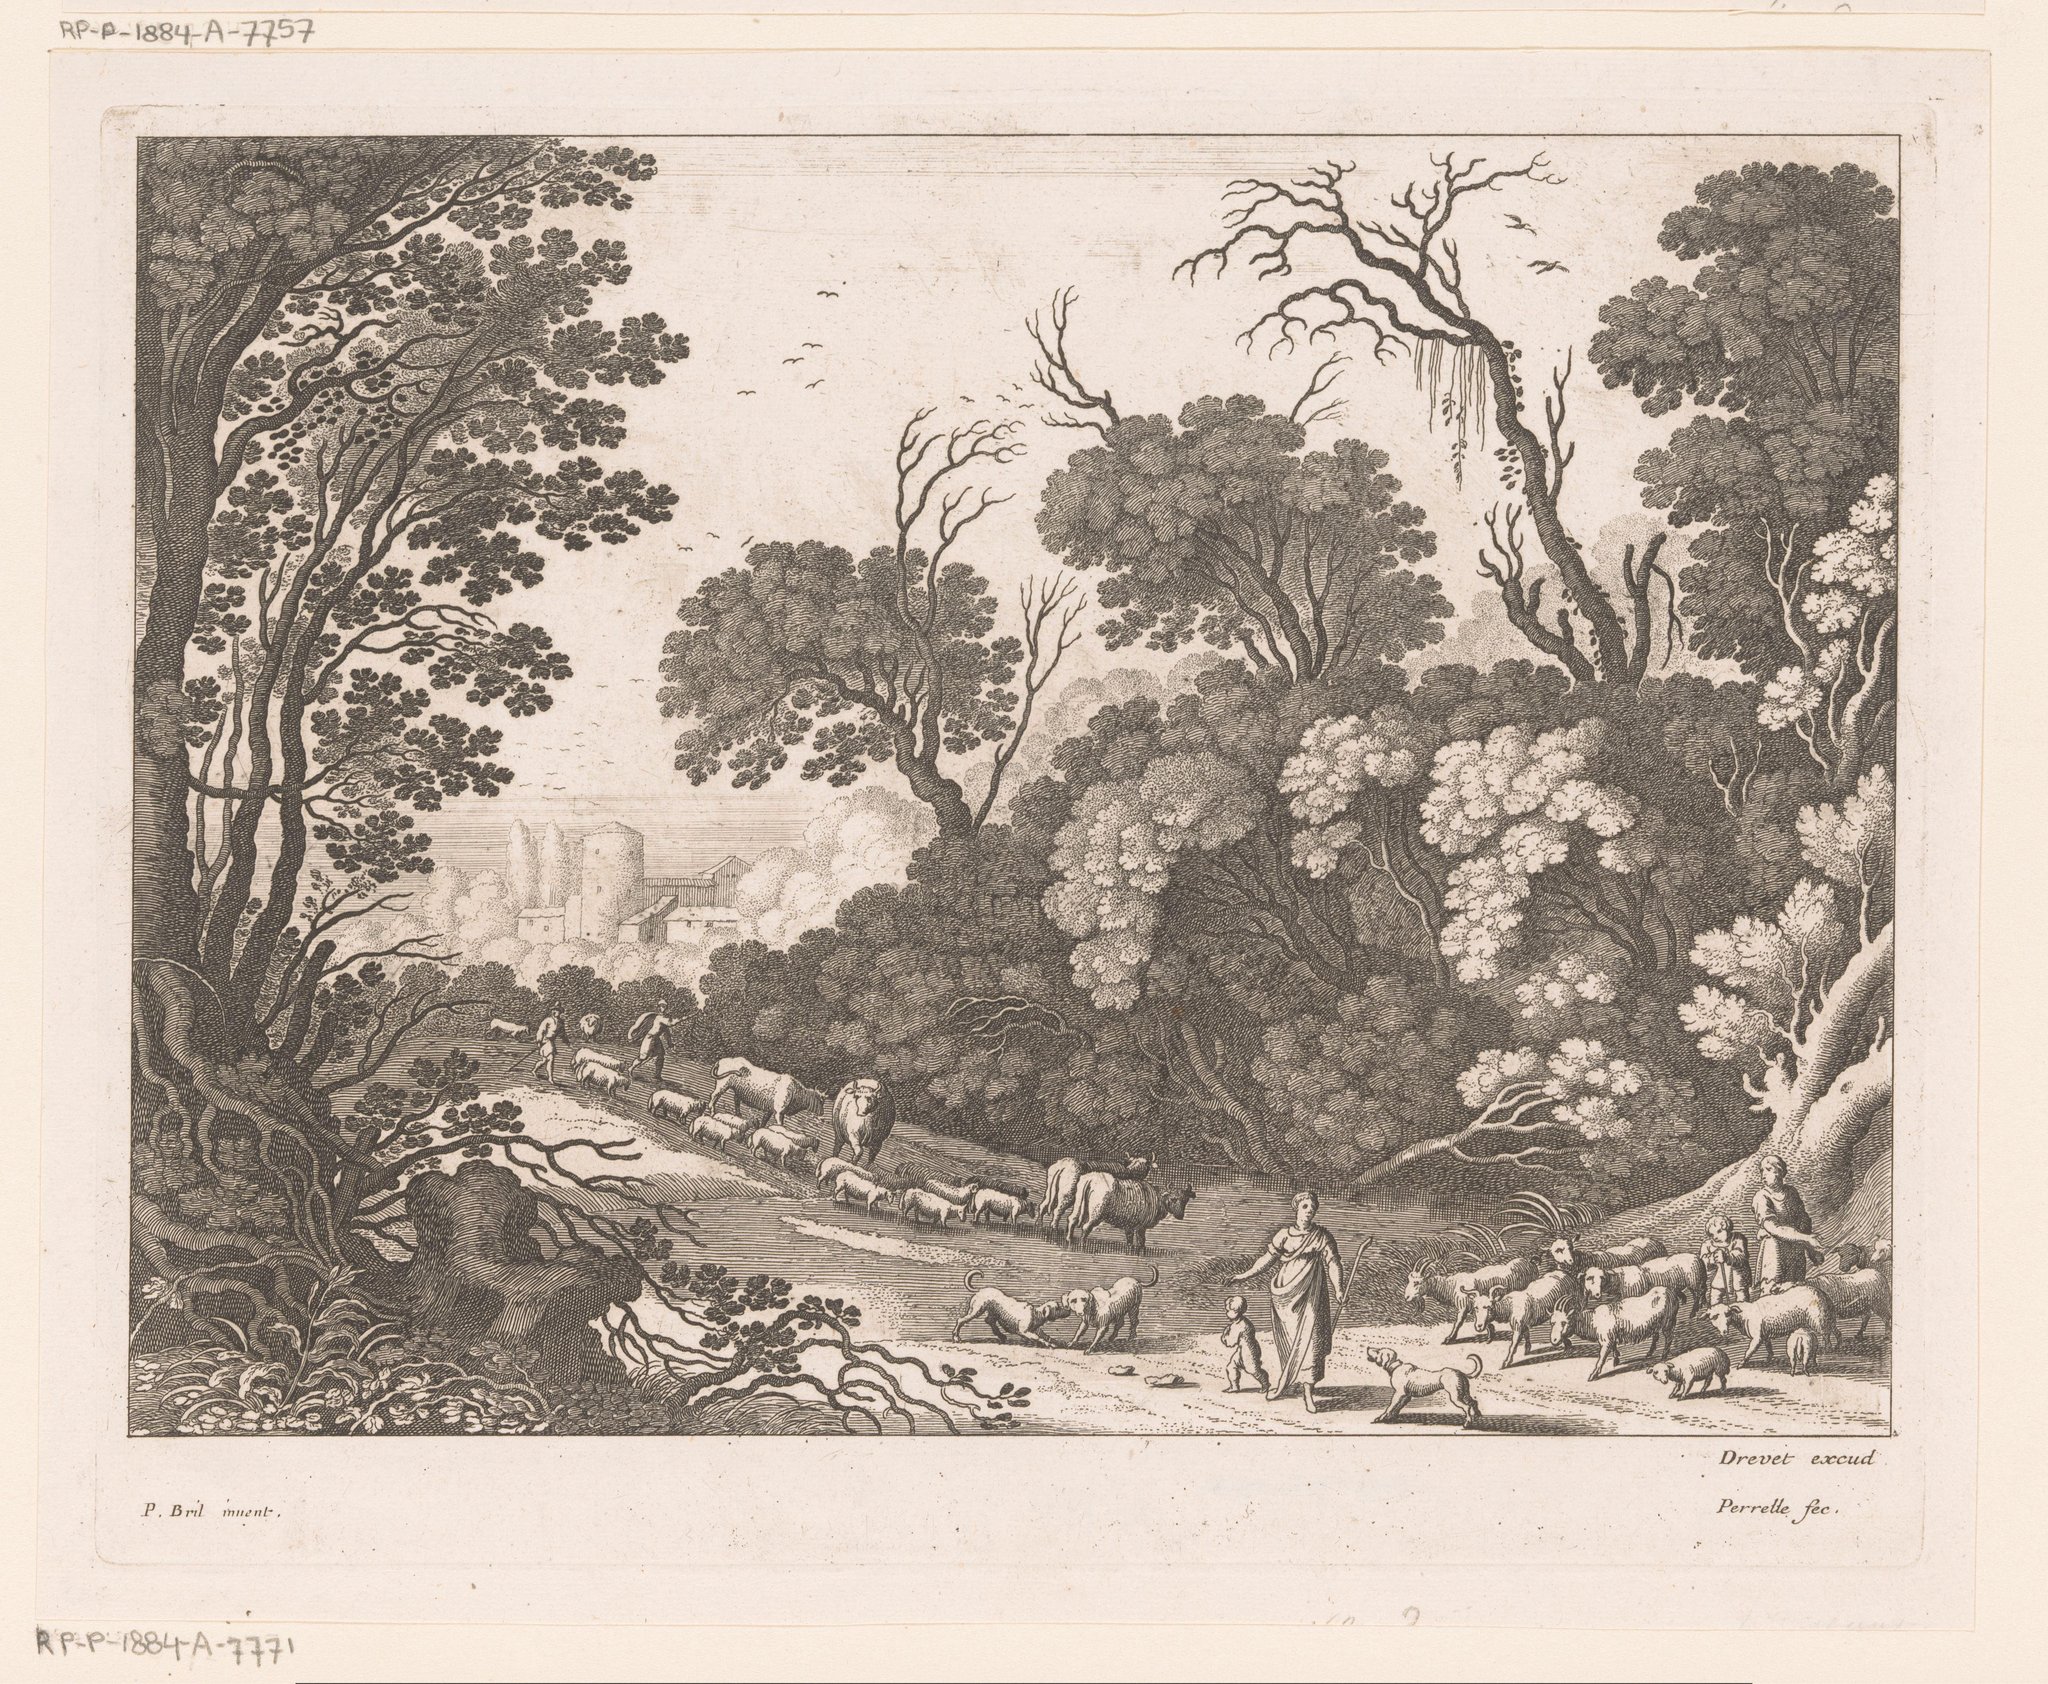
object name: print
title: Herders met kudde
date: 1673-1695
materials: paper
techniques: etching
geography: paris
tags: landscapes, pastorals, arcadian scenes, herd, flock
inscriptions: collector's mark: Lugt 2228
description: Prenten met het signatuur 'Perelle' kunnen zowel door vader Gabriel als door zonen Nicolas en Adam gemaakt zijn.